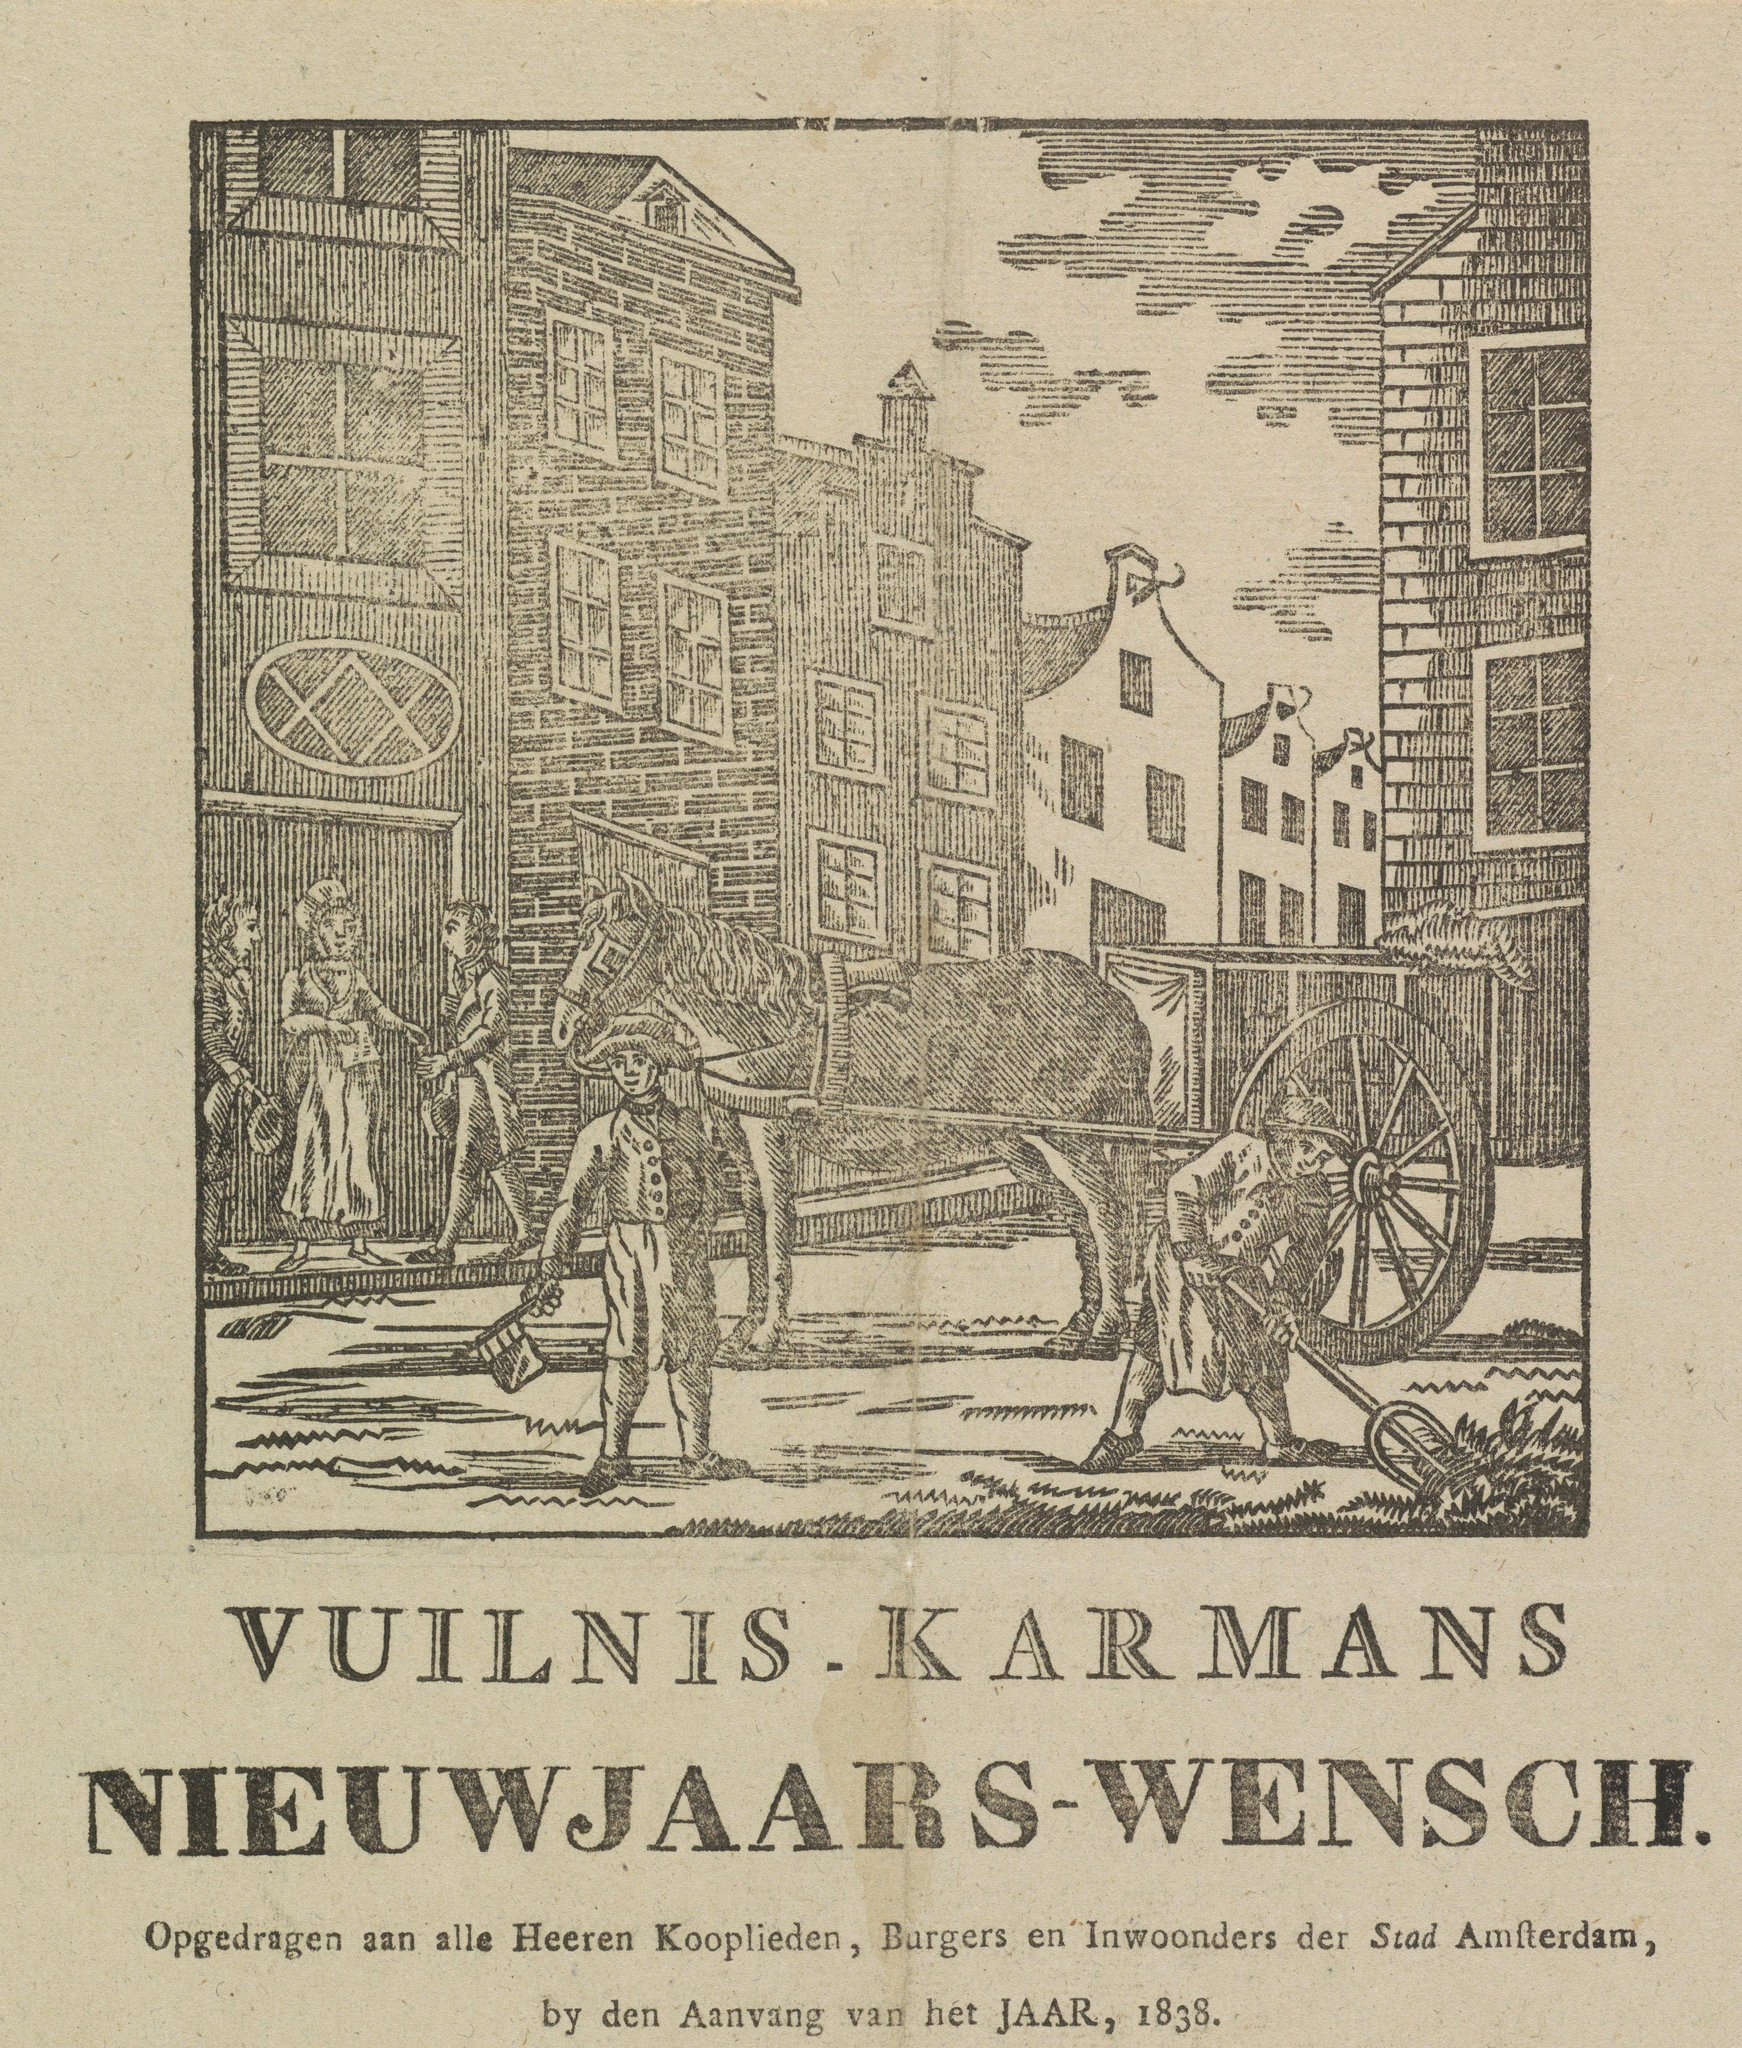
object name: new year card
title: Nieuwjaarswens van de vuilnismannen van Amsterdam voor het jaar 1838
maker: Anonymous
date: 1837-1838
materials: paper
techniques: letterpress printing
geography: amsterdam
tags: street, garbage collection, amsterdam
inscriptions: collector's mark: Lugt 2228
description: Nieuwjaarswens van de Amsterdamse vuilnismannen voor het jaar 1838. Gezicht in een straat te Amsterdam waar een man het vuil van de straat schept en een andere man met de ratel draait. Twee andere mannen halen bij een huis geld op. Met gedicht in twee kolommen. Van de vuilniskarman in de wijk no. 19: Johannes Bongaards.